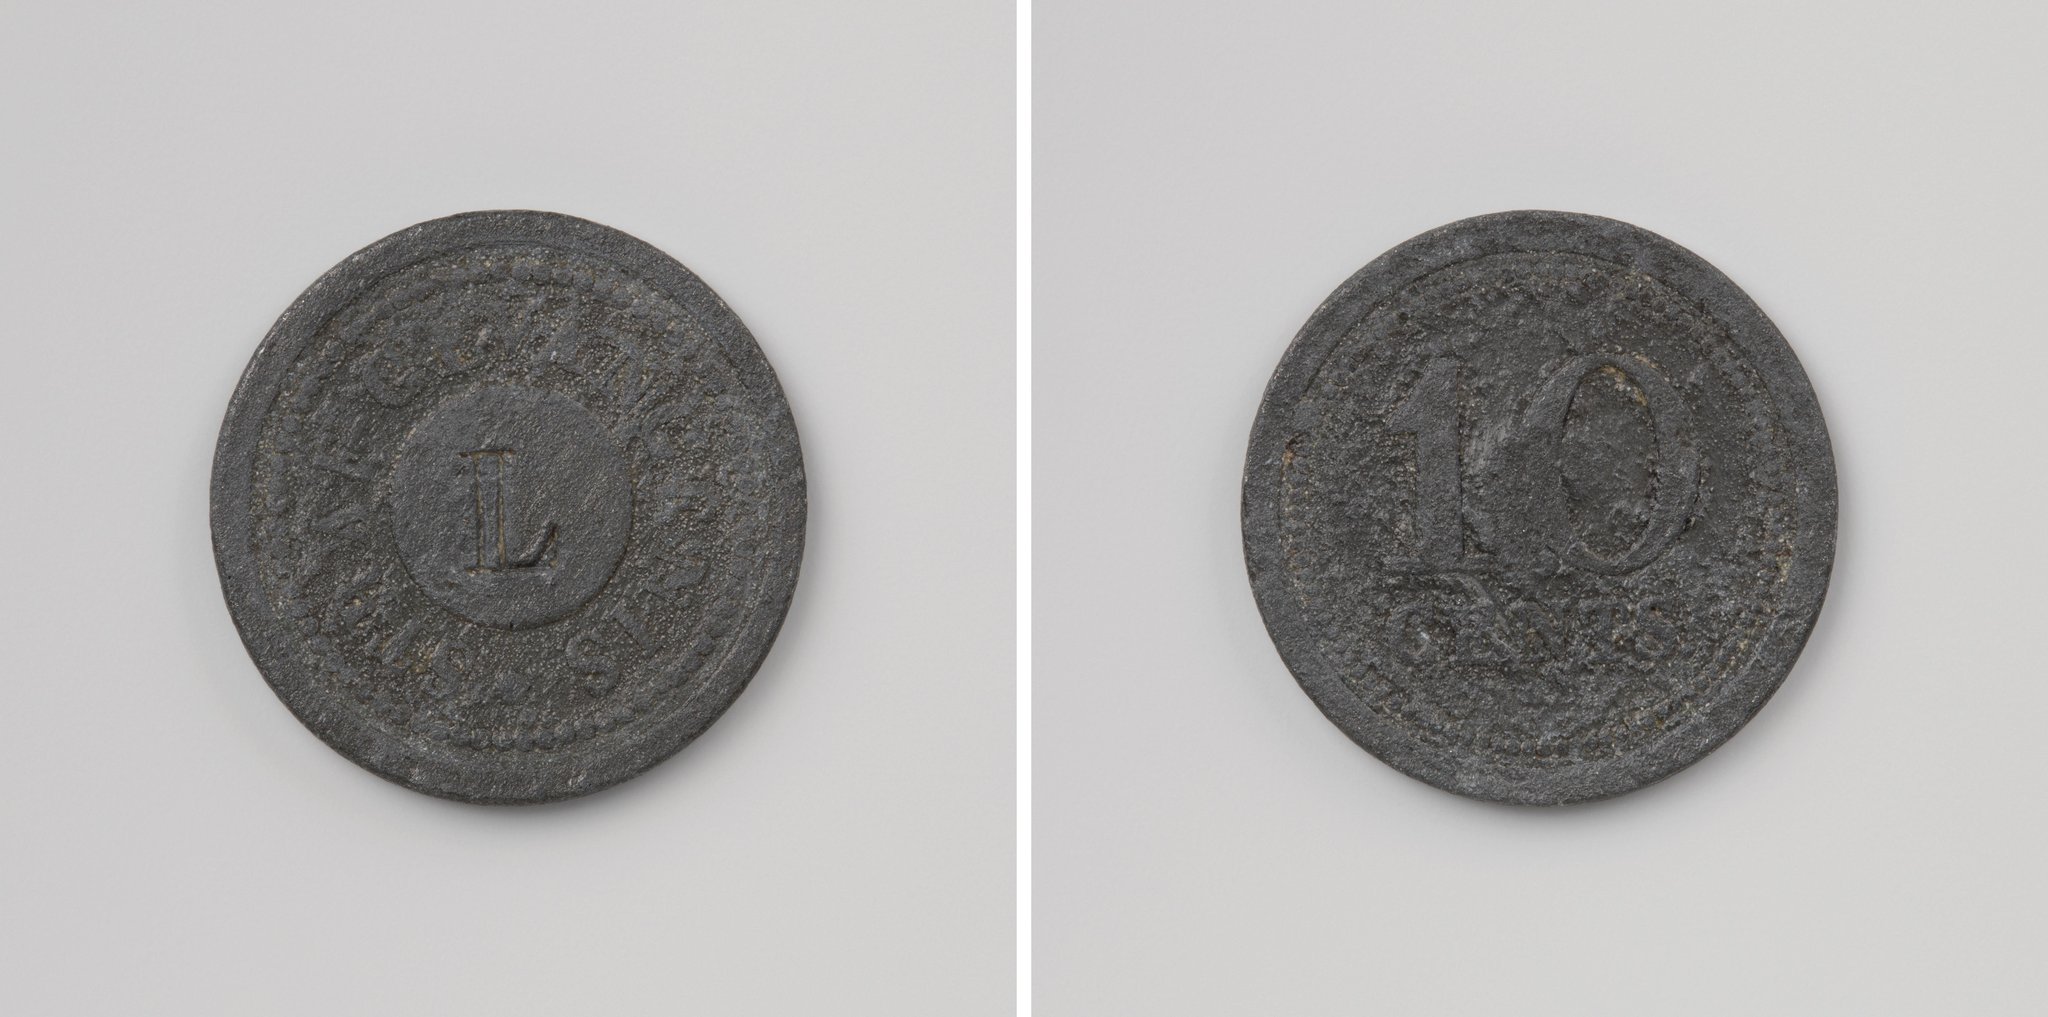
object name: tien cent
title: Militaire strafgevangenis te Leiden, huismunt ter waarde van tien cents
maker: Anonymous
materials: zinc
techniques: striking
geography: utrecht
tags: leiden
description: Zinken betaalpenning. Voorzijde: letter L binnen omschrift. Keerzijde: waardeaanduiding